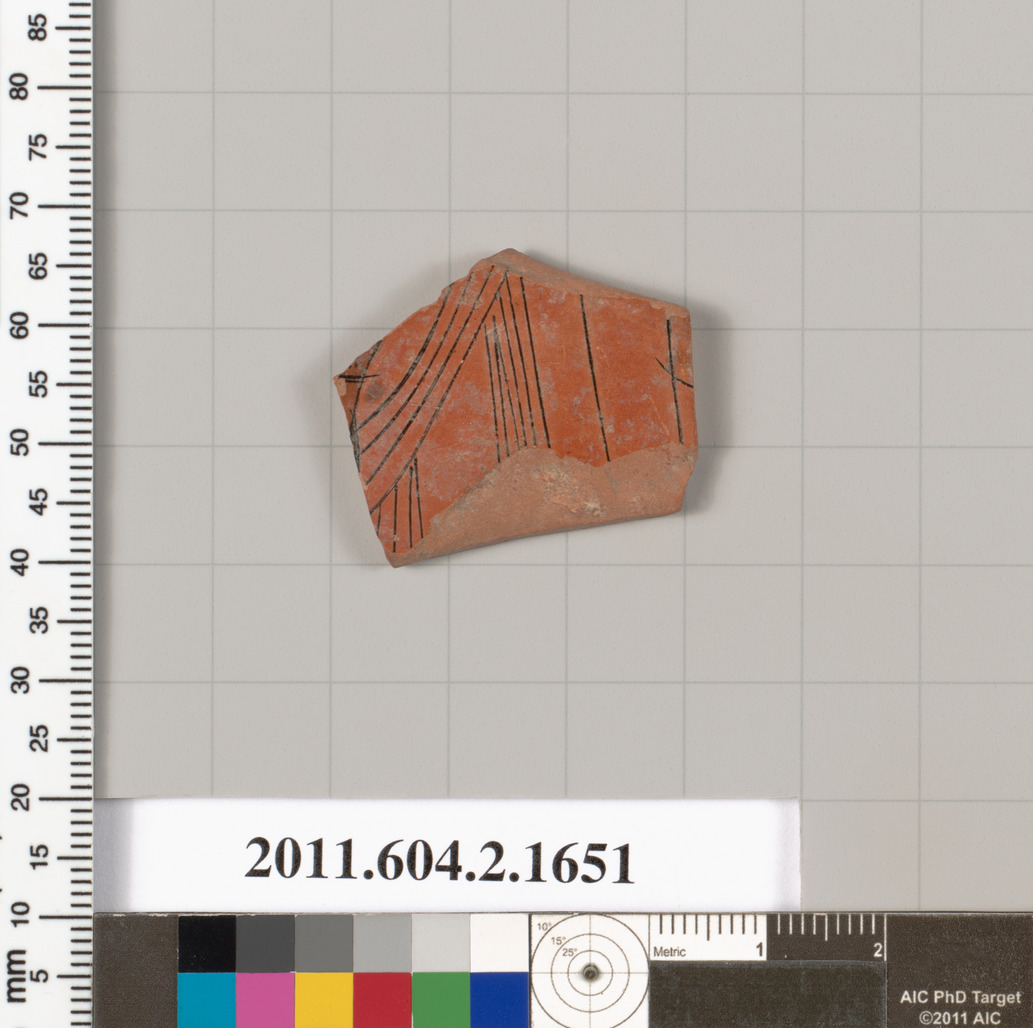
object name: skyphos fragment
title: Terracotta fragment of a skyphos (deep drinking cup)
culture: greek, attic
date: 475-451 BCE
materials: terracotta